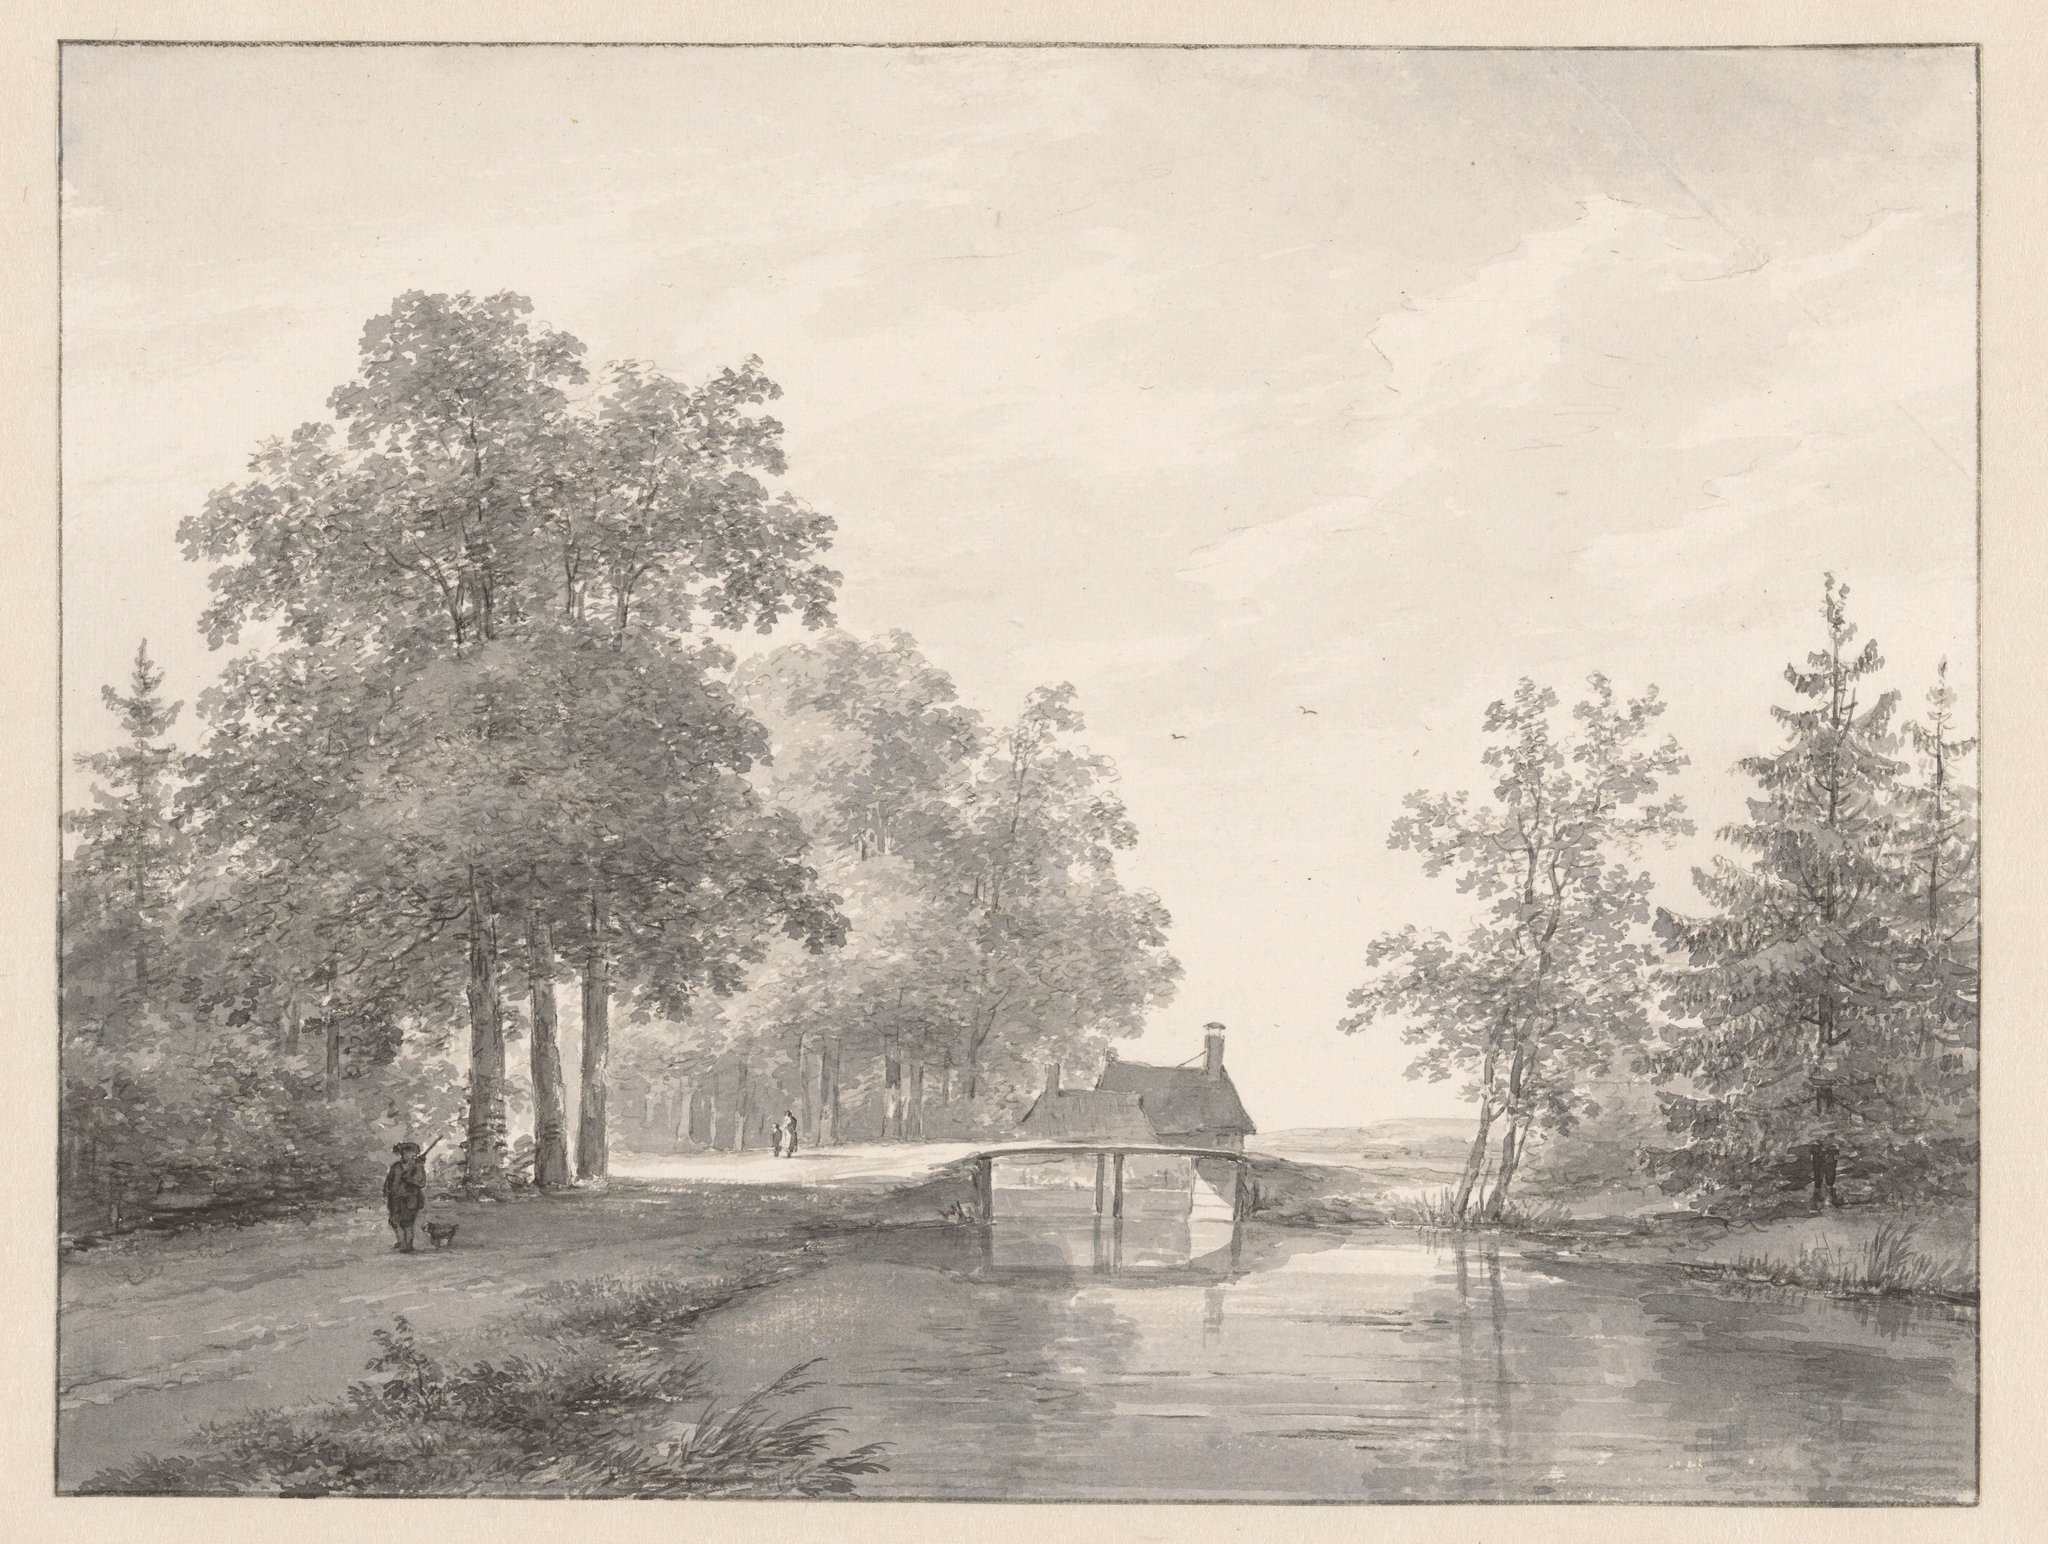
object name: drawing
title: Landschap met vaart en brug, links een jager met hond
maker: andreas schelfhout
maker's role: draughtsman, painter, print maker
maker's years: 1787-1870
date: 1797-1870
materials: chalk, paper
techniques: brush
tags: hunter, landscape with bridge, viaduct or aqueduct